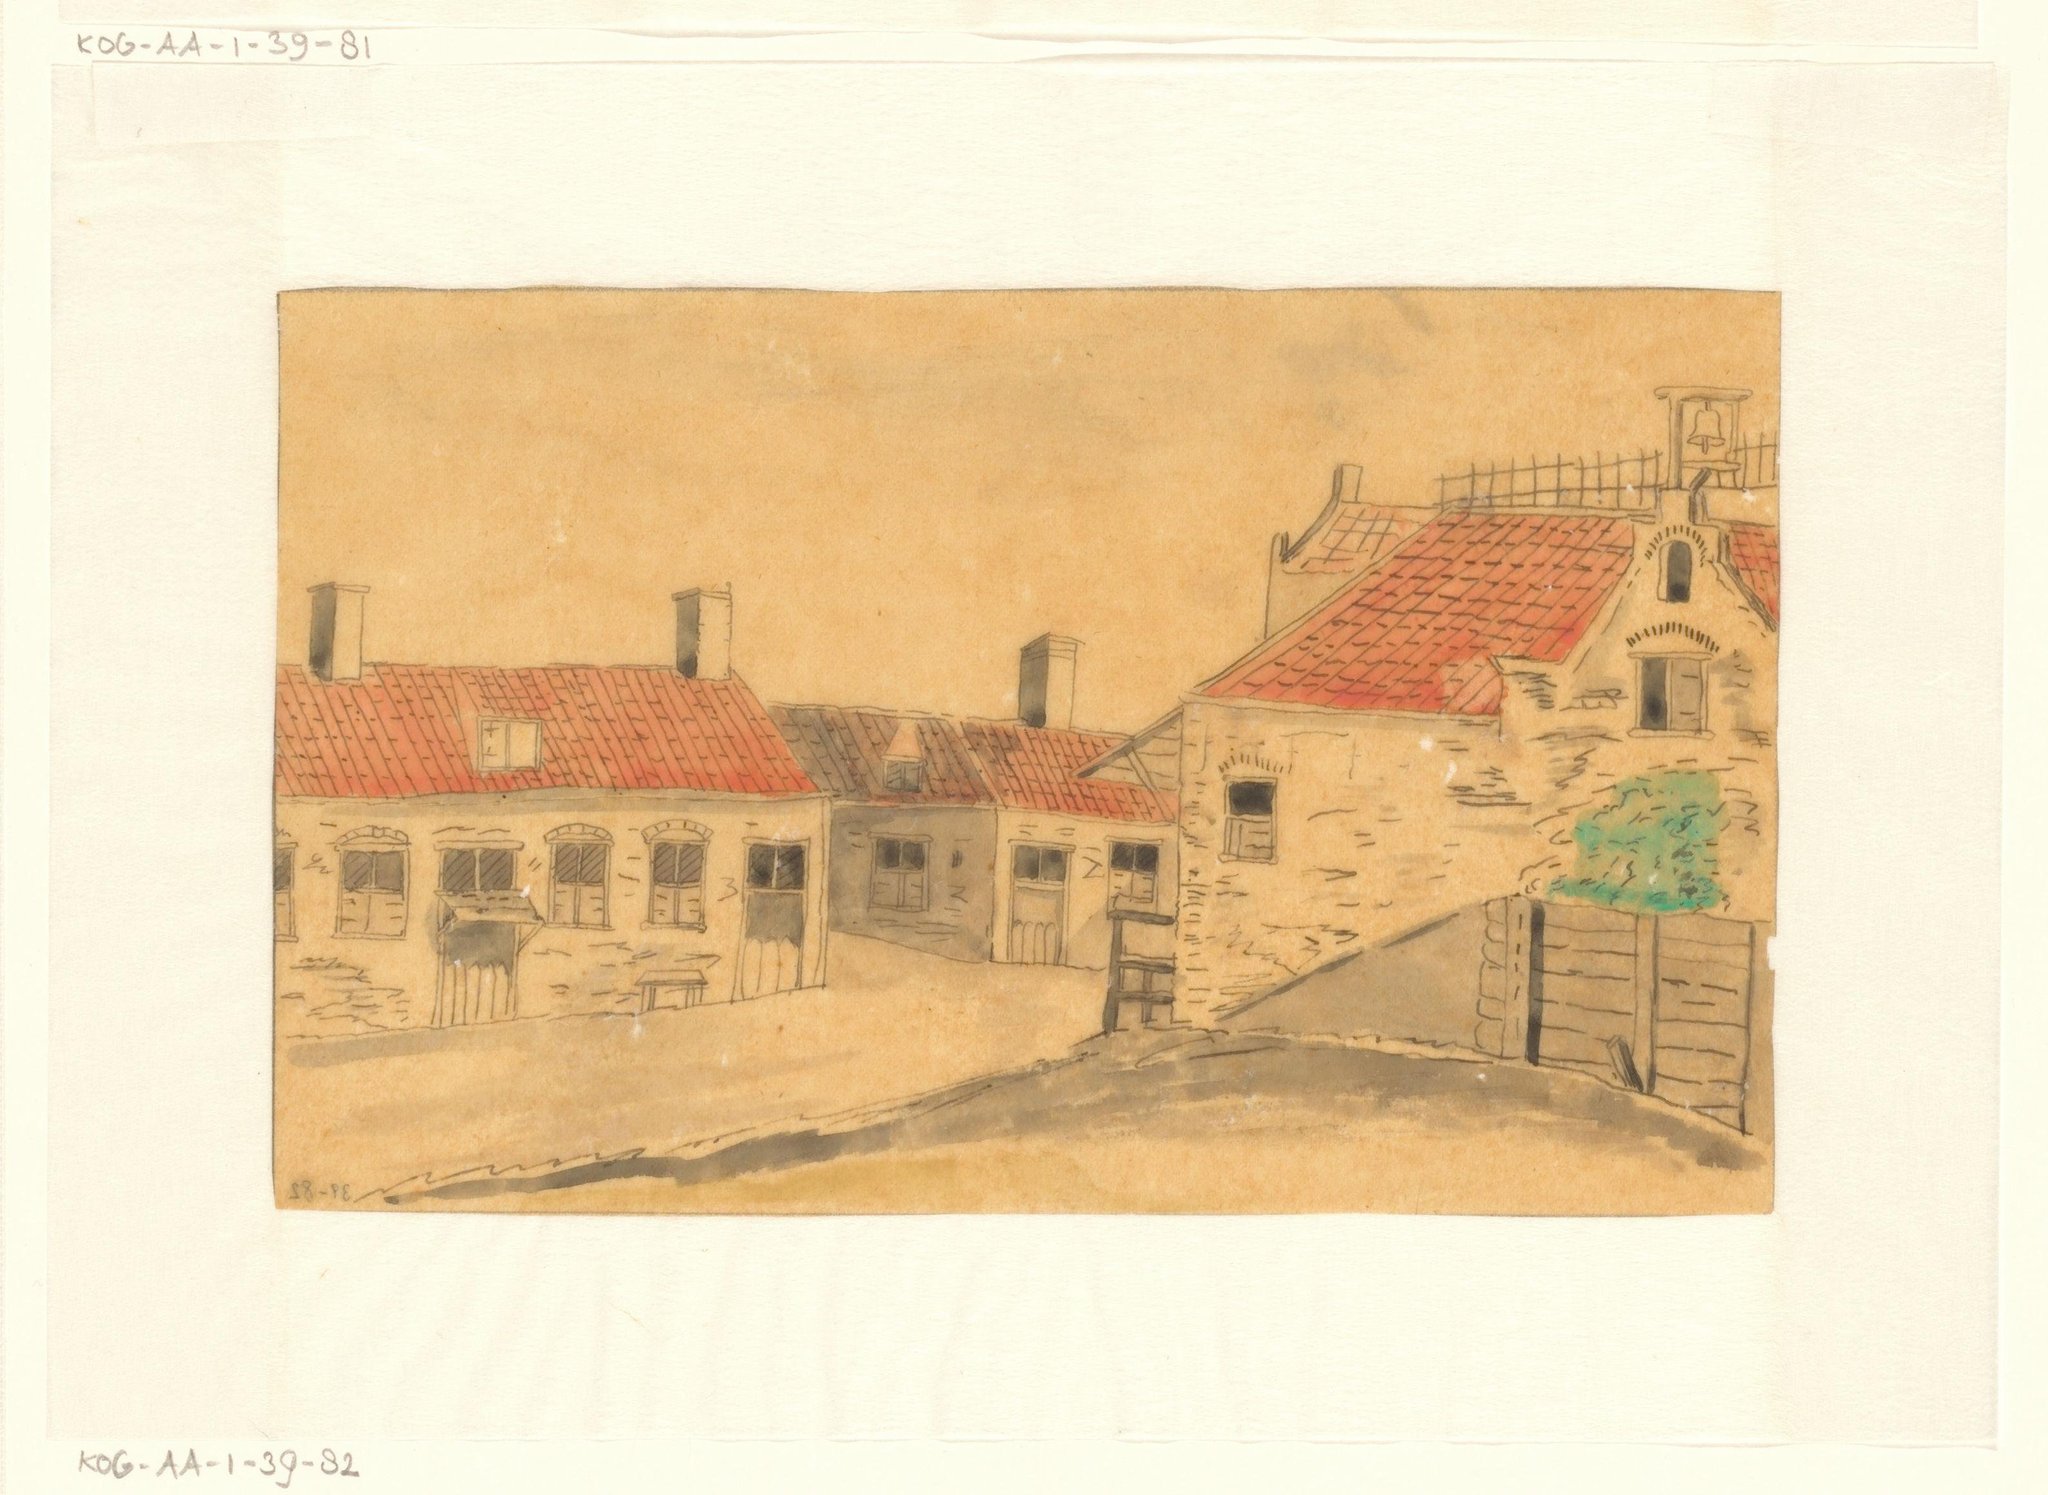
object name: drawing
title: Gezicht op een straat te Amsterdam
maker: Anonymous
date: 1900-1950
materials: ink, paper, watercolor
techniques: brush, pen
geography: amsterdam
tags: city-view in general; 'veduta', the usual house or row of houses, street, amsterdam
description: Onderwerpsrubriek binnen de Atlas Amsterdam: Toevlucht voor Onbehuisden (?).